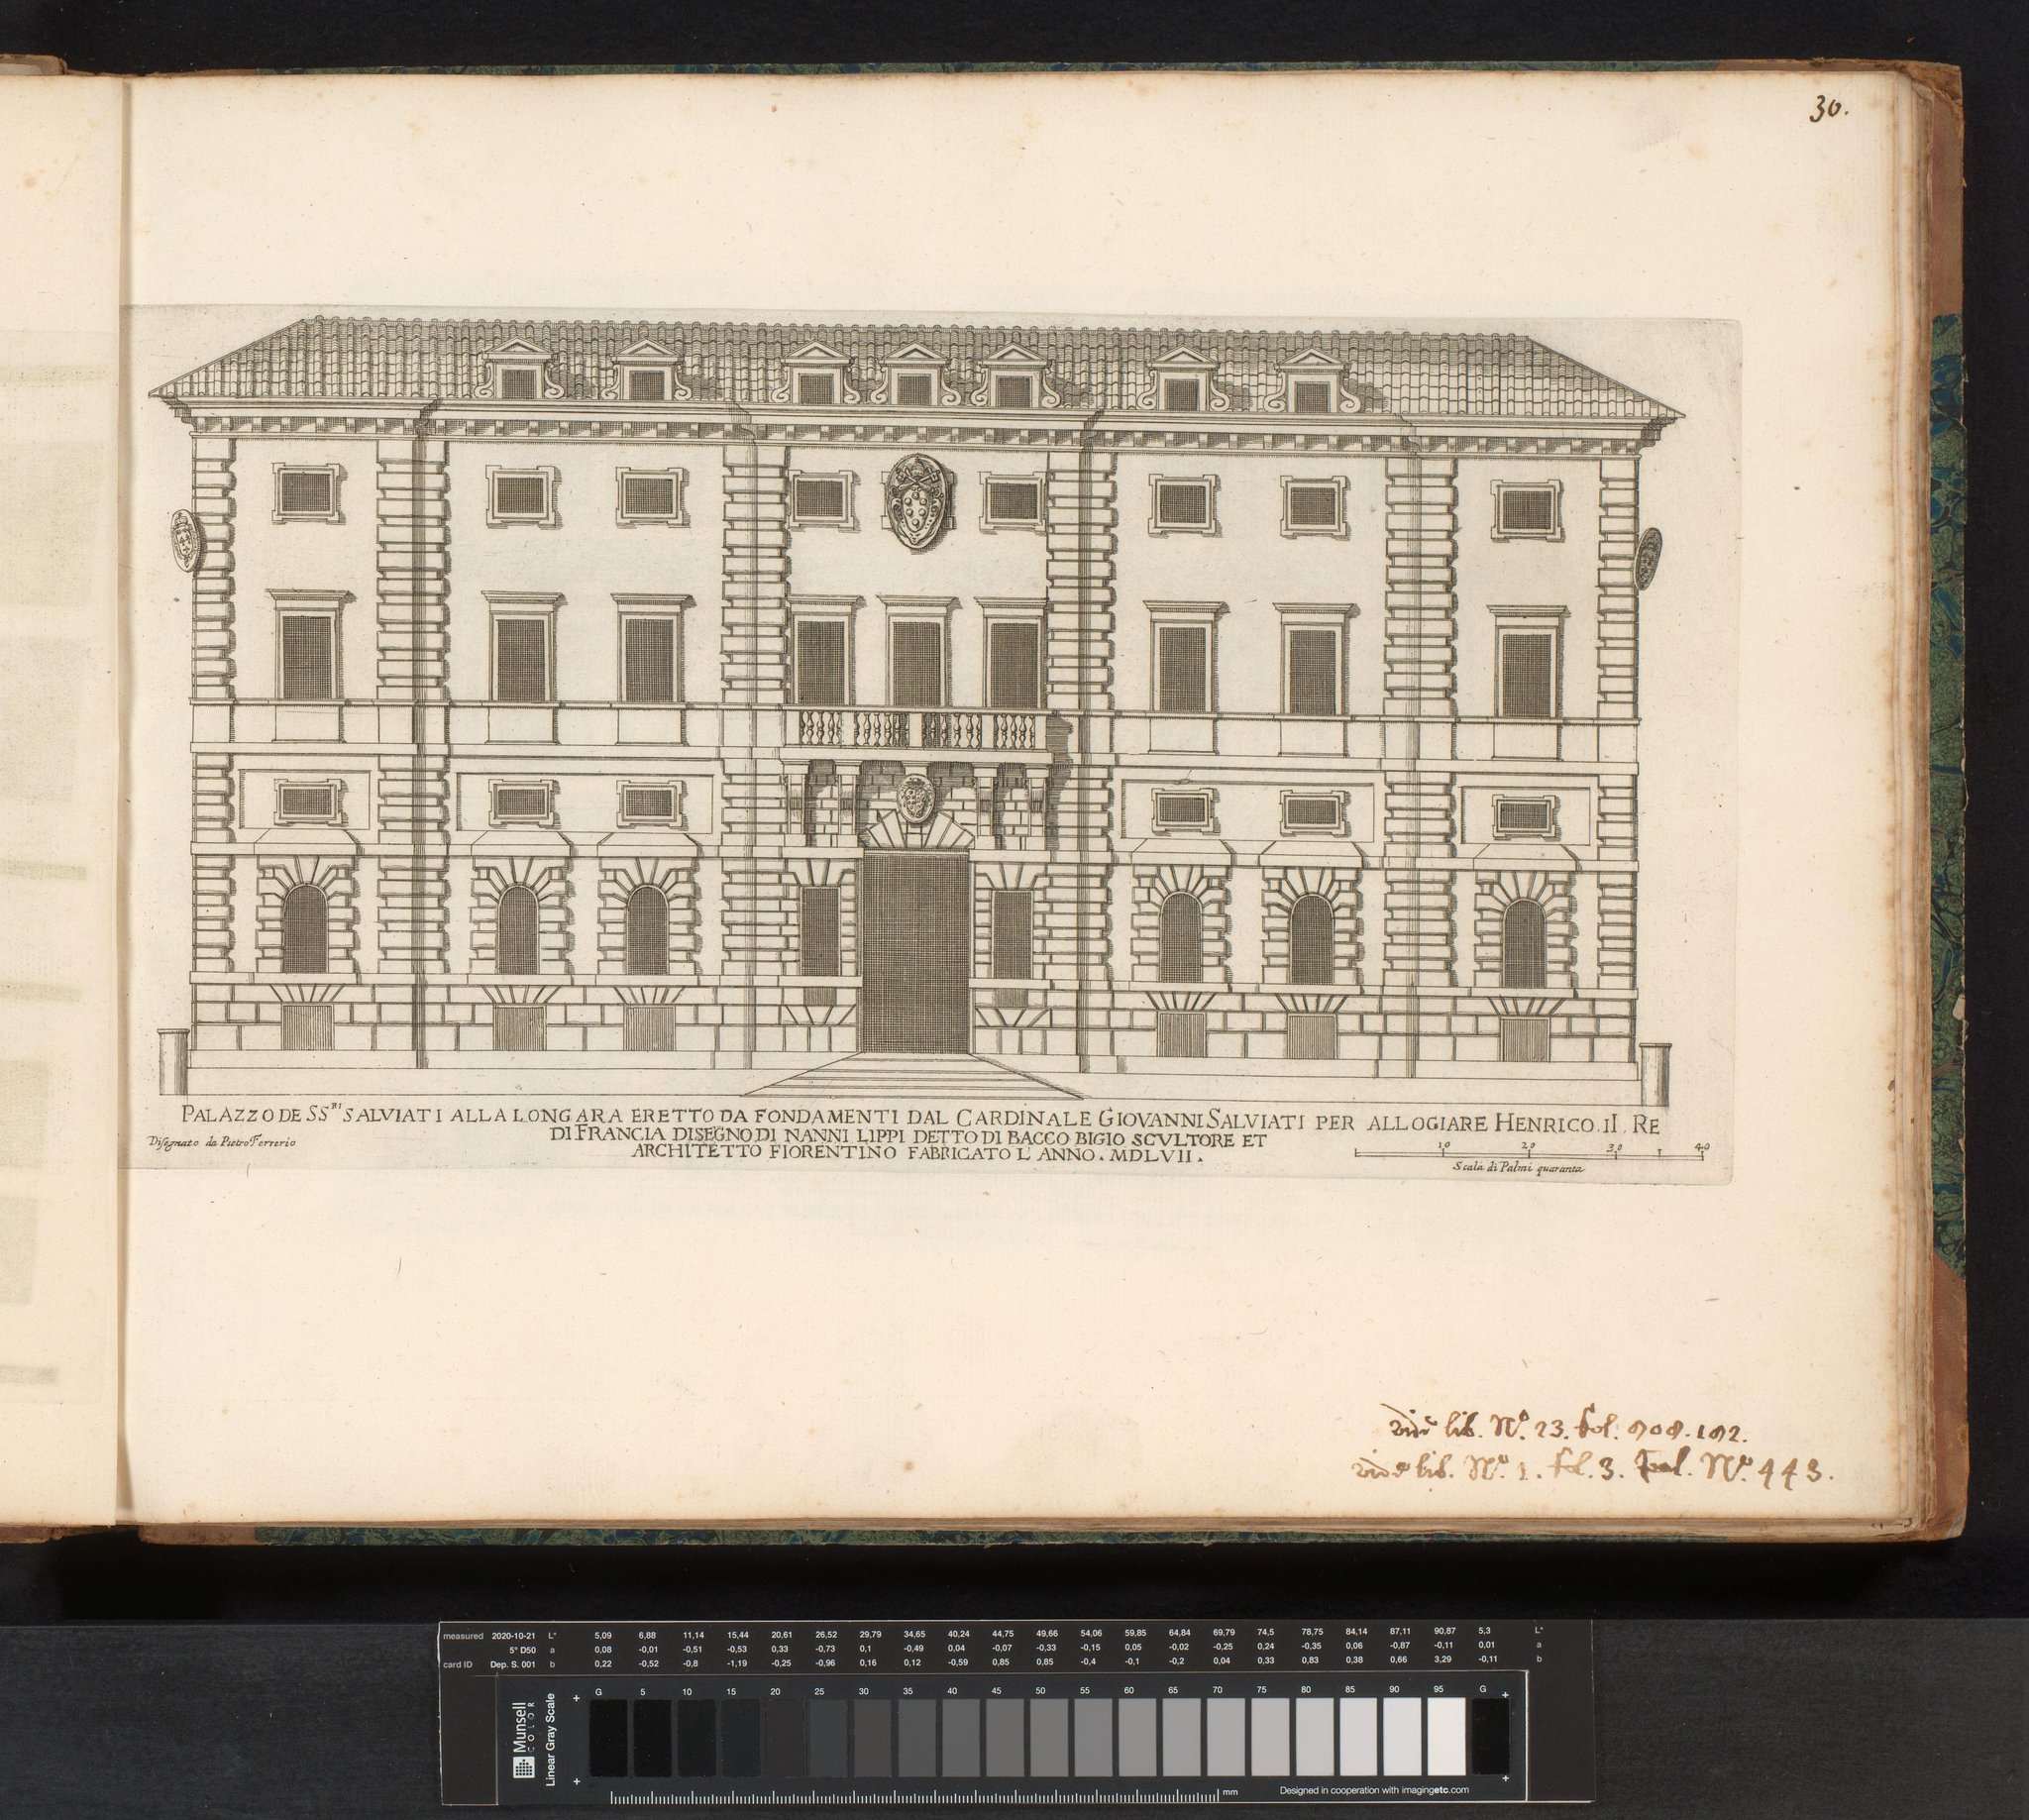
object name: print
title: Palazzo de SS.mi Salvati alla longara eretto da fondamenti dal cardinale Giovanni Salviati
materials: paper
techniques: etching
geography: italy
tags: palace, façade (of house or building)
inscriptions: number: ‘30’, inscription: ‘Ende lib. No. 23. fol. 807. 182./ Ende lib. No. 1. fol. 3...’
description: Deze prent maakt deel uit van de reeks getiteld: Palazzi di Roma. Deze reeks bestaat uit twee boeken. Boek één getiteld: Palazzi di Roma dei più celebri architetti..., bestaat uit 44 prenten die worden toegeschreven aan Giovanni Battista Falda (naam staat enkel op prent 27) en uitgegeven door Giovanni Giacomo de'Rossi. Deze 44 prenten zijn bekend in twee staten (met en zonder nummer). Boek twee getiteld: Nuovi disegni dell'architetture... libro secondo, bevat 66 prenten door Giovanni Battista Falda en Simone Felice. Deze 66 prenten zijn bekend in twee staten (met en zonder nummer).